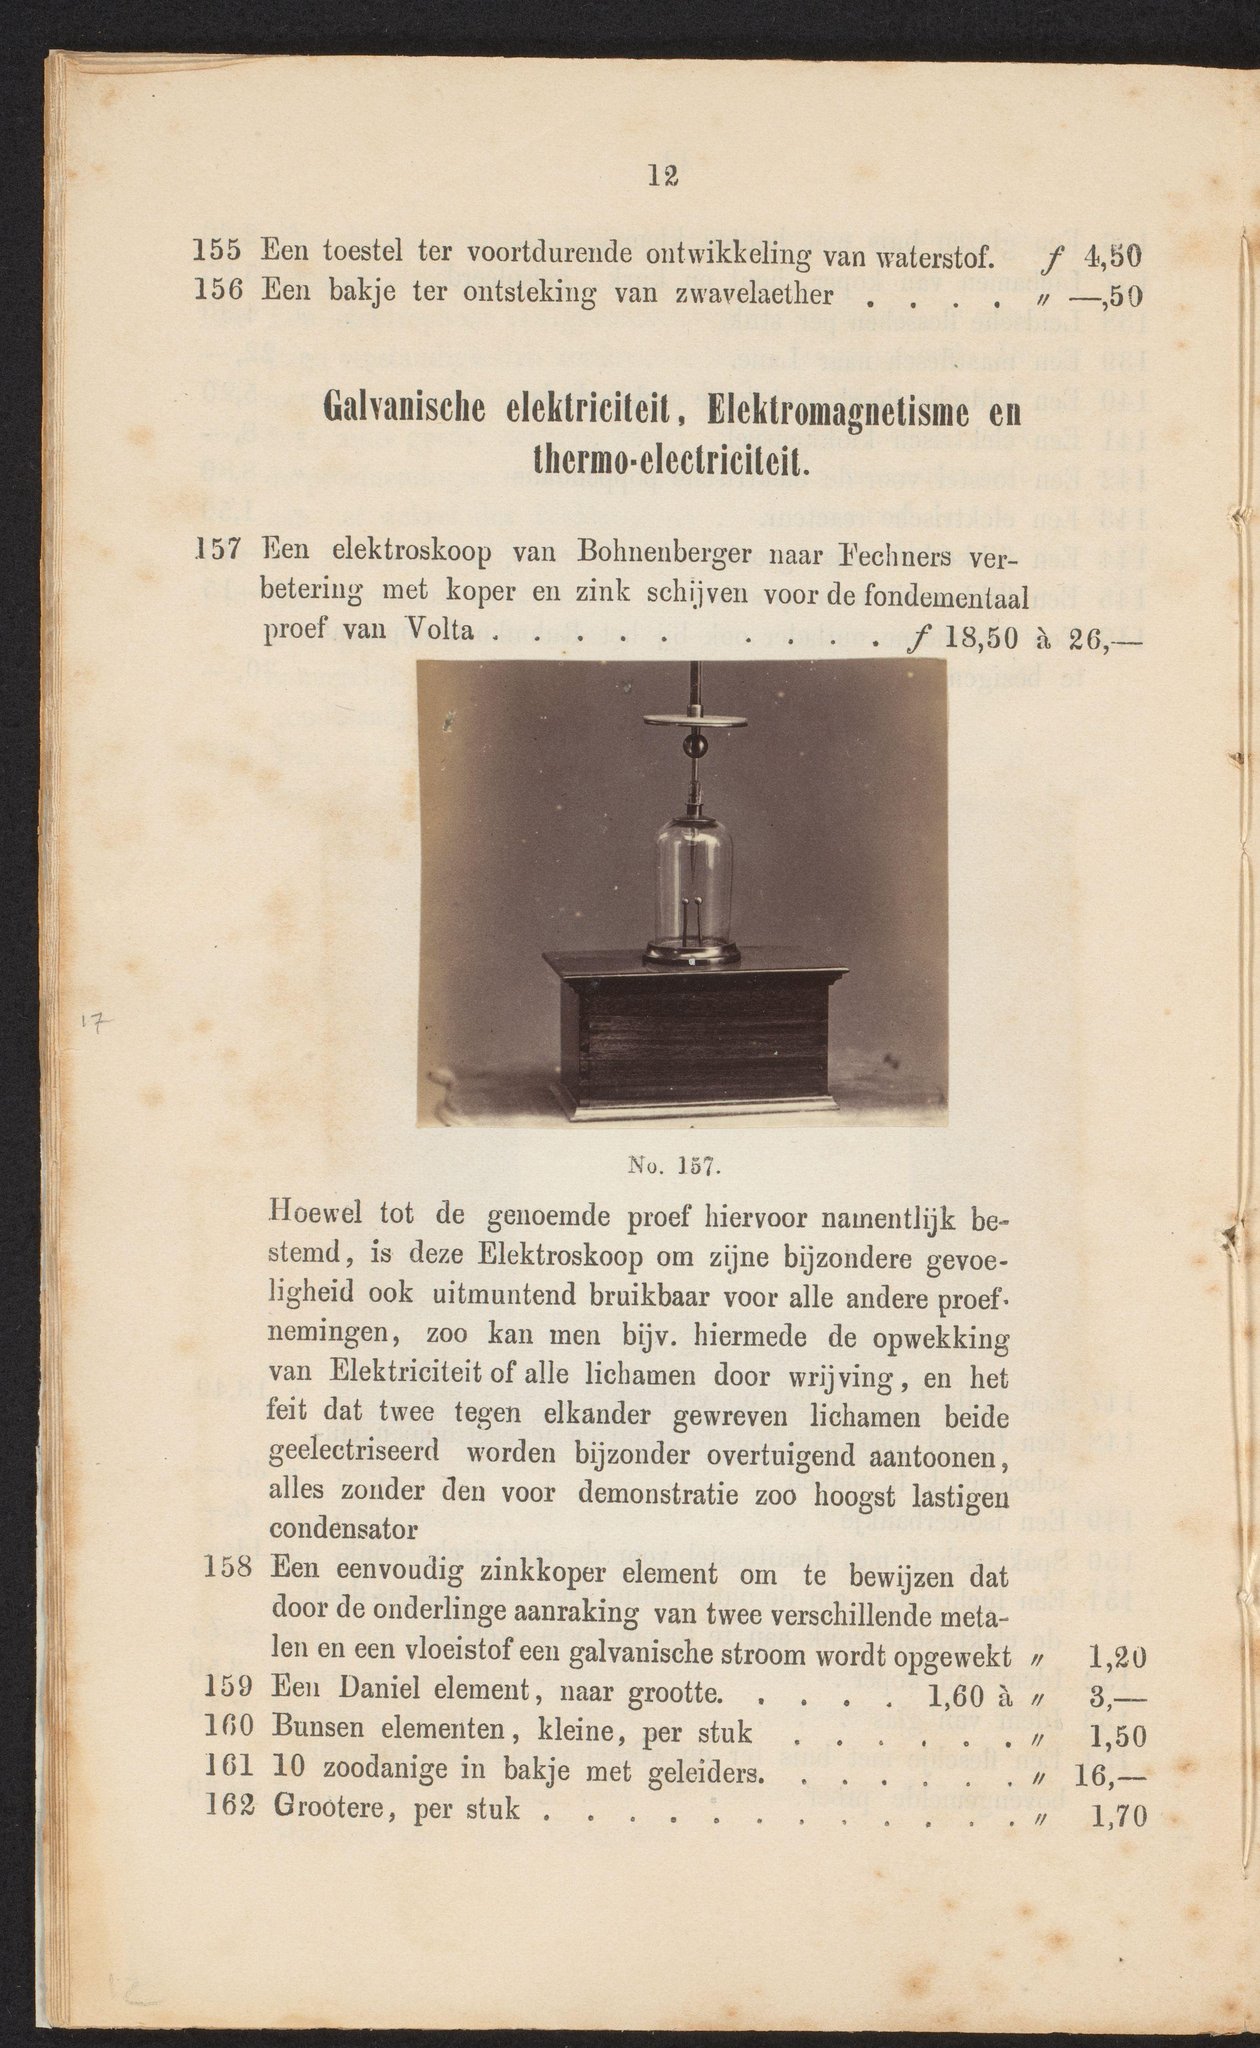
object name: page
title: Electroscoop van Bohnenberger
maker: fredrich wilhelm funckler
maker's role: instrument maker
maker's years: 1836-1886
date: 1857-1867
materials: photographic support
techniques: albumen print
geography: netherlands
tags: physics (+ tools, instruments; laboratory equipment ~ scientific research)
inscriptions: number: ‘No. 157.’